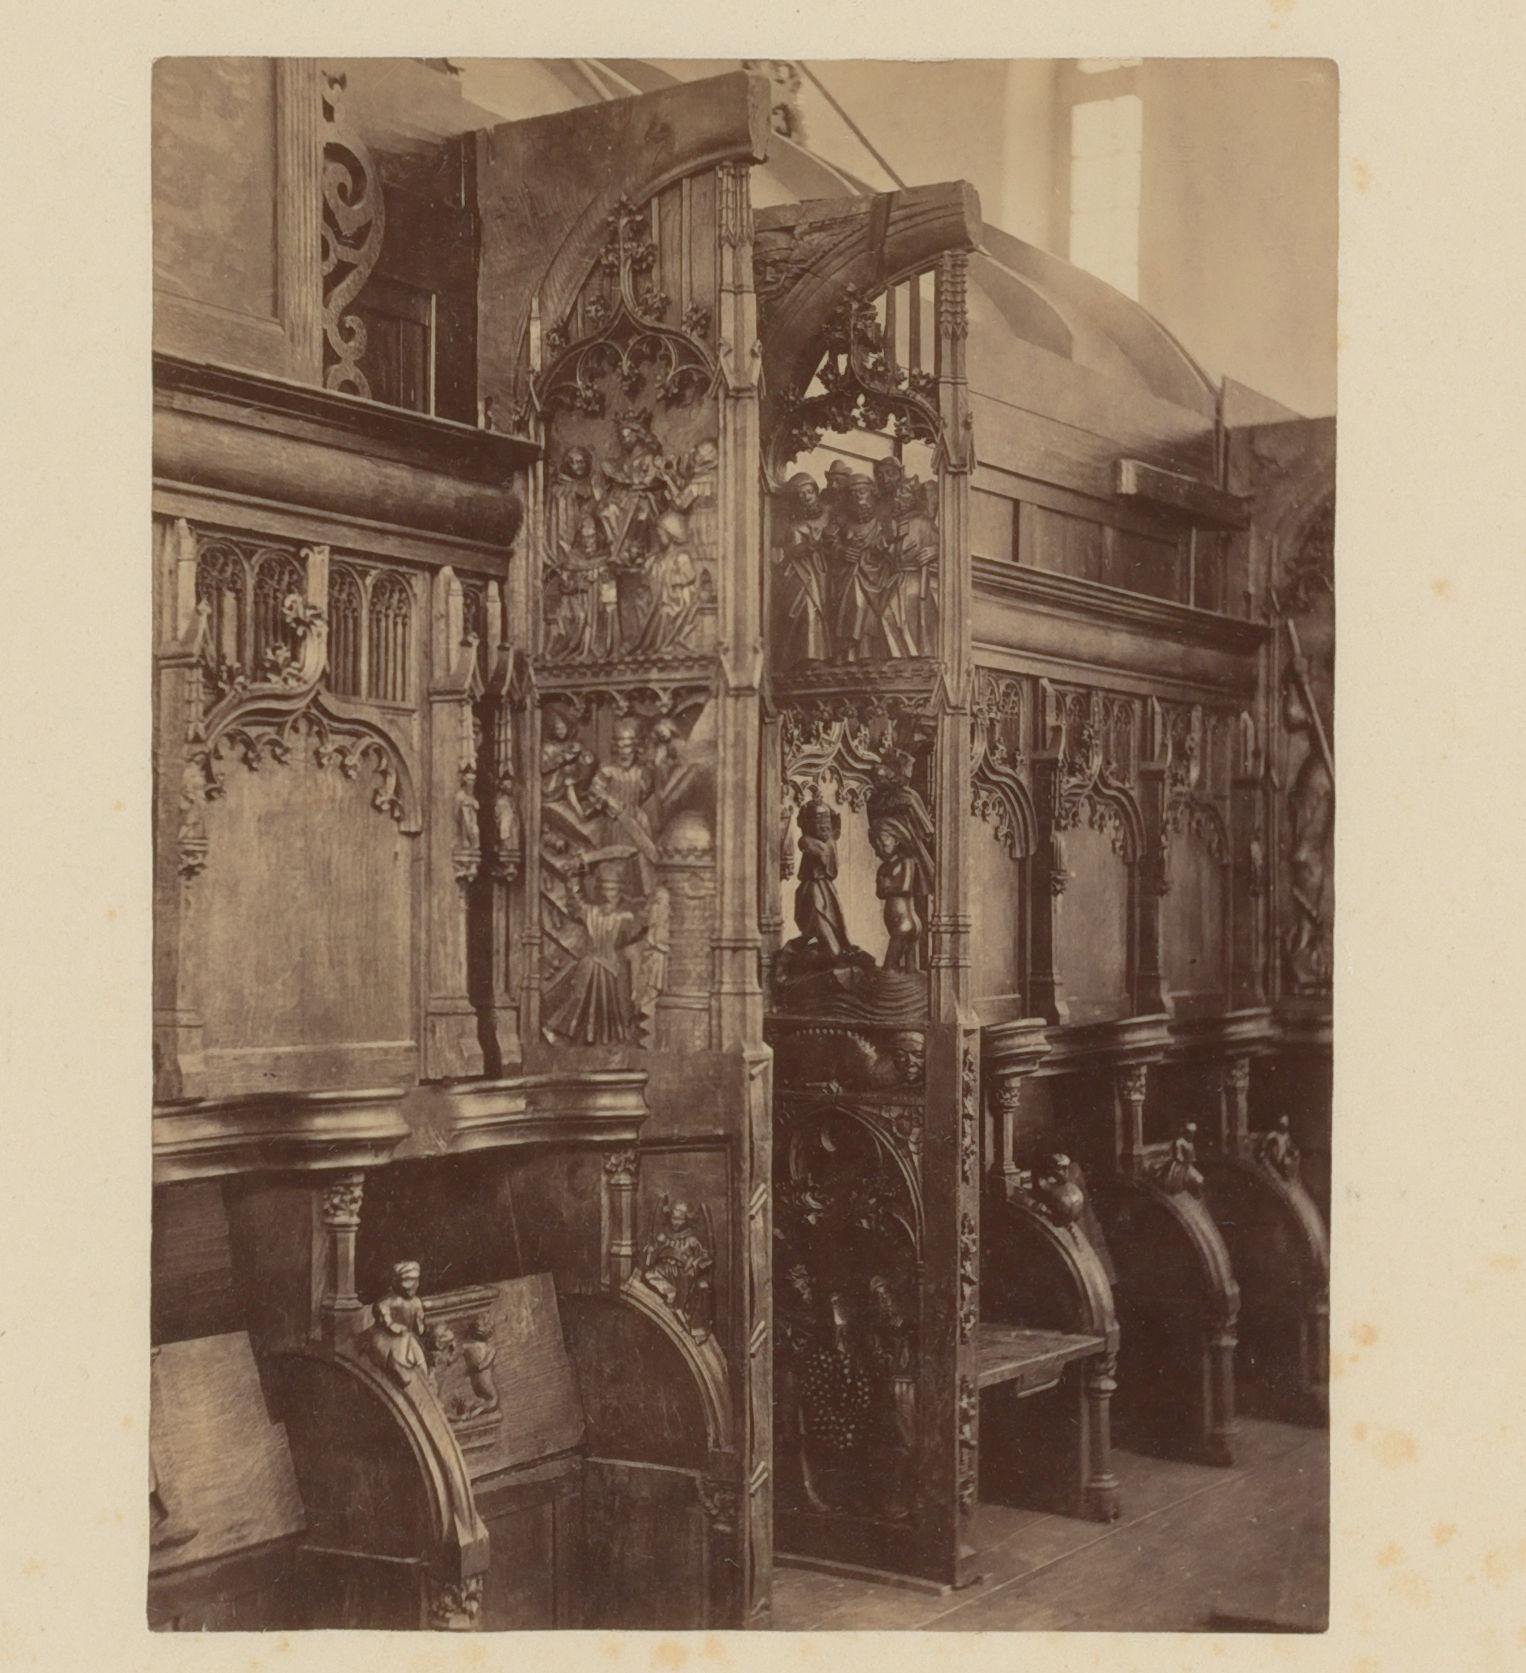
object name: photograph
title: Houtsnijwerk op de koorbanken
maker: g.m. märckelbach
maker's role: publisher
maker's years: 1853-1904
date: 1879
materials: photographic support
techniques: albumen print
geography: bolsward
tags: carving ~ applied arts, piece of sculpture, reproduction of a piece of sculpture, wood carver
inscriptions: collector's mark: Lugt 1641, collector's mark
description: In een advertentie wordt de fotoserie aangeboden: HH. Liefhebbers van Antiquiteiten. GOTHIEKE BANKEN uit de XVe Eeuw. St. MARTINIKERK.--BOLSWARD. 8 Photographieën à f 4.50. ANTIEKE PREEKSTOEL, uit het midden der XVIIe EEUW. 4 Photographieën à f 2.25. Uitgave van: GEBRs. CORDES, Photografen [and] G.M. MÄRCKELBACH, Boek- en Kunsthandel, BOLSWARD. (Het nieuws van den dag: kleine courant, 12-07-1879.)